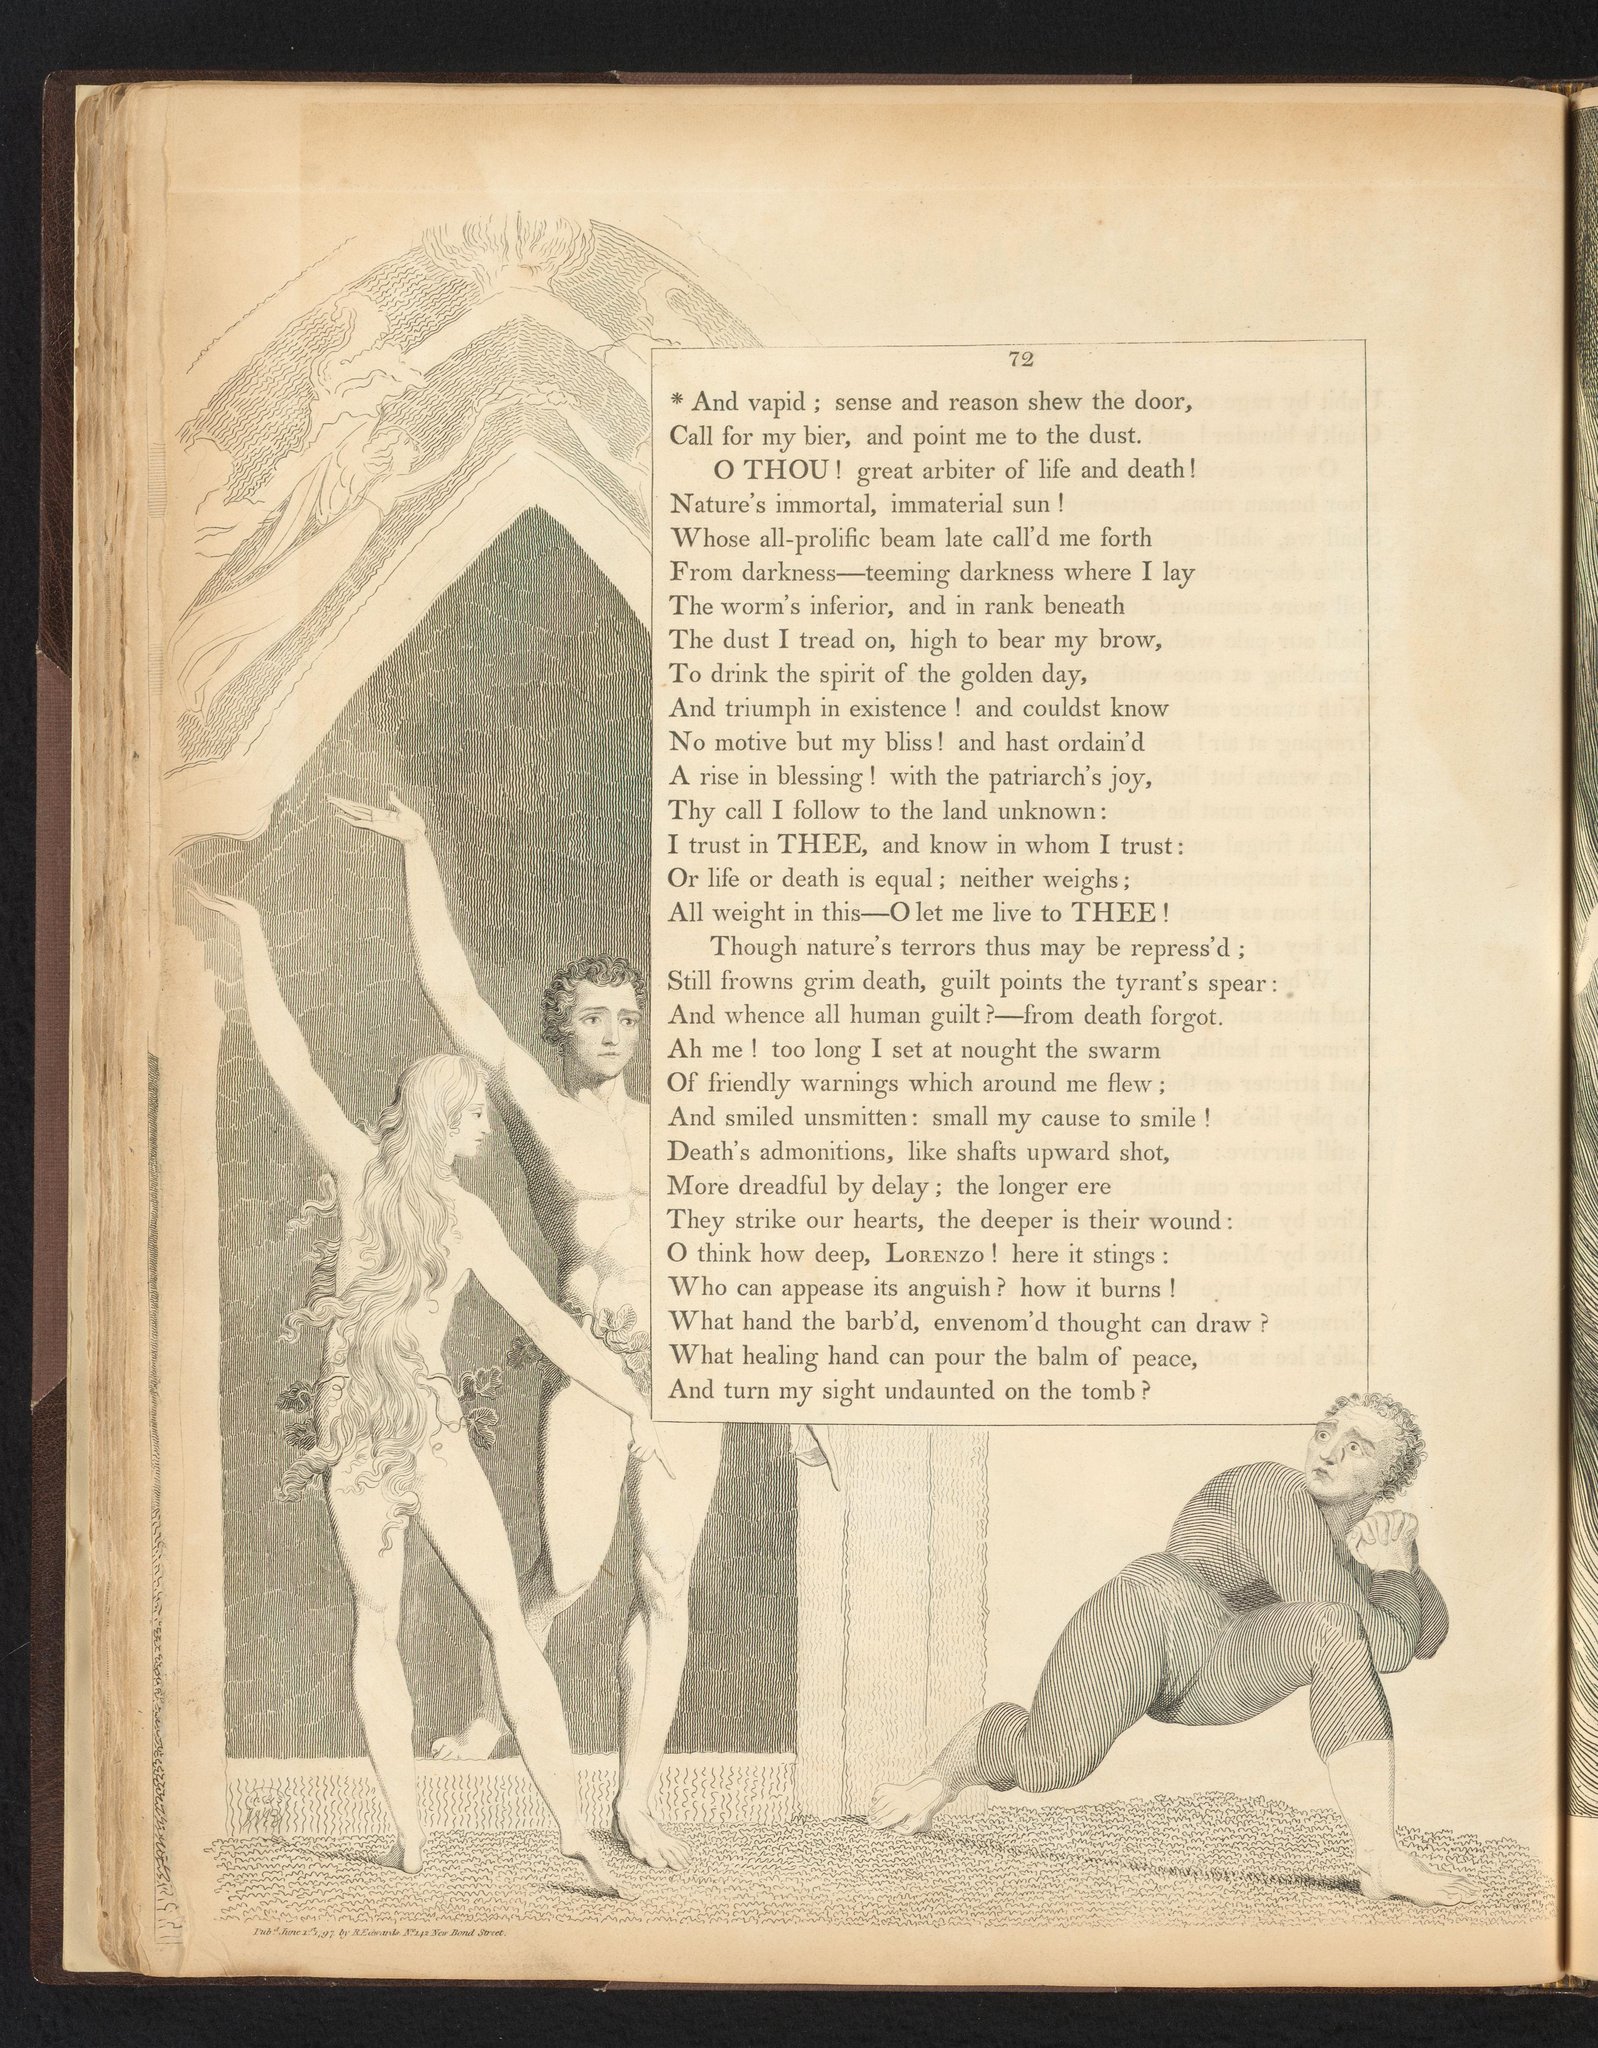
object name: page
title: Adam en Eva en een gehurkte man met gevouwen handen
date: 1796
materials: paper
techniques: engraving, etching, letterpress printing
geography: london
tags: squatting, crouching figure, adam and eve (not in biblical context)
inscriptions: : ‘* And vapid ; sense and reason shew the door, (...)’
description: Prent maakt deel uit van een boek, bladzijde 72. Tekst in het Engels op het recto en verso.